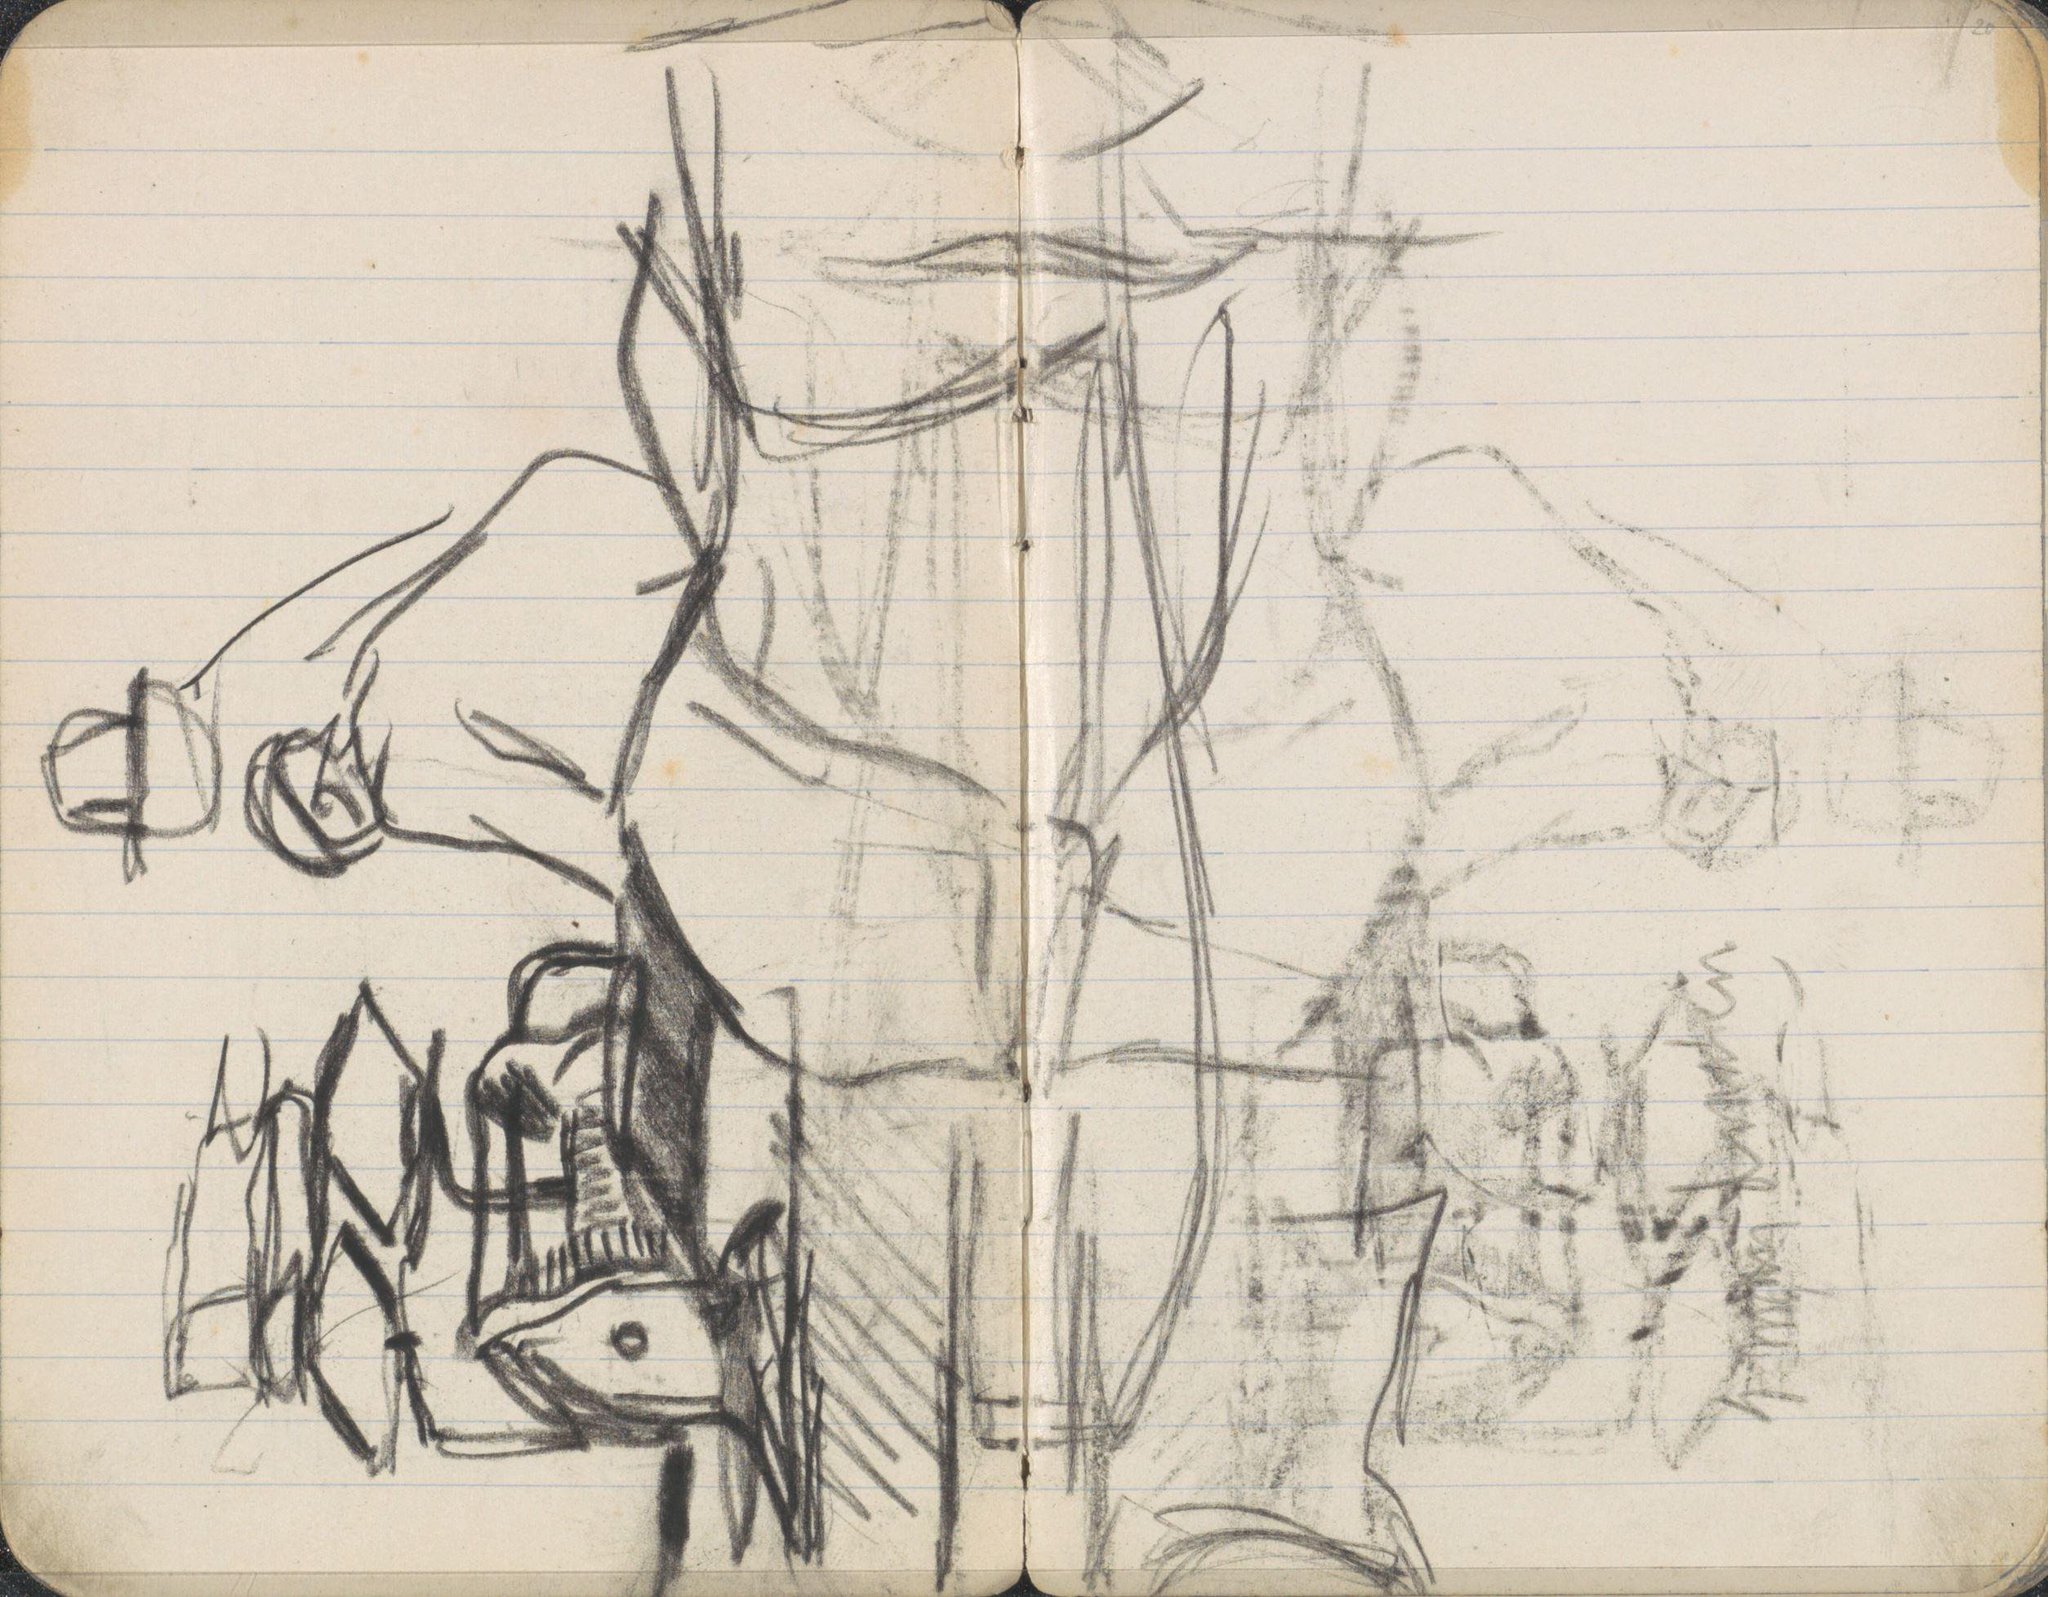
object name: sketchbook leaf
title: Twee figuren bij een paard-en-wagen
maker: george hendrik breitner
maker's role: draughtsman, painter, print maker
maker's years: 1857-1923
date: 1896-1897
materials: chalk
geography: amsterdam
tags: tools and machines ~ building, horse, (farm) wagon, freight wagon, cart, amsterdam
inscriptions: annotation: ‘[...]’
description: Twee aangespannen paarden. Op de achtergrond een werktuig. Pagina 19 en pagina 20 uit een schetsboek met 39 bladen.